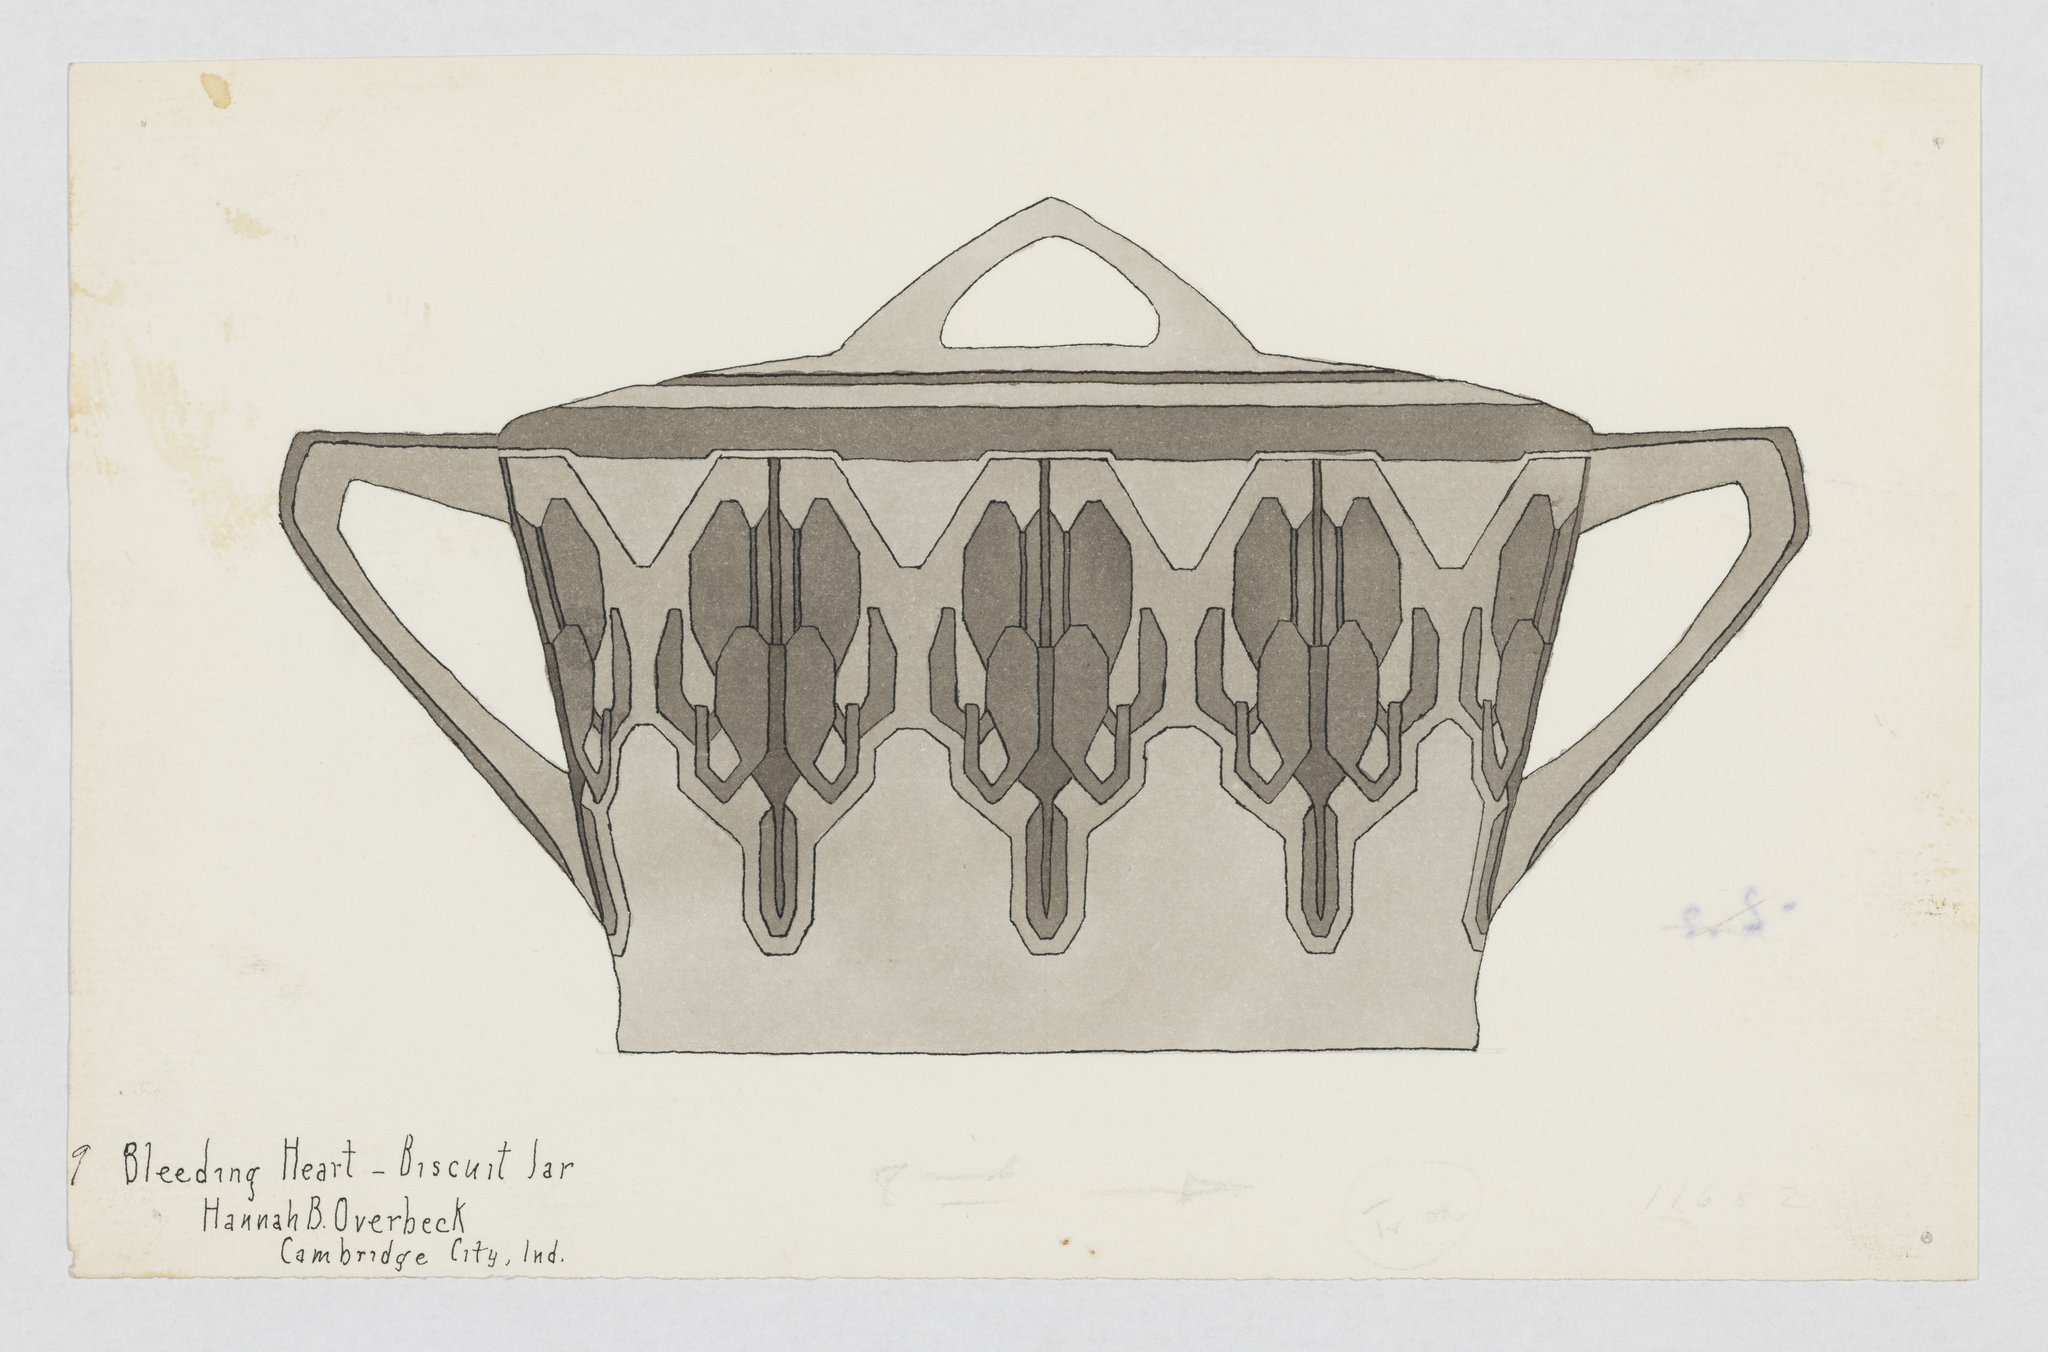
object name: drawing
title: Bleeding Heart Biscuit Jar Design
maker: hannah borger overbeck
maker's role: artist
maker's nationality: american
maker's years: 1870-1931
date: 1913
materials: ink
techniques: brush, pen, wash